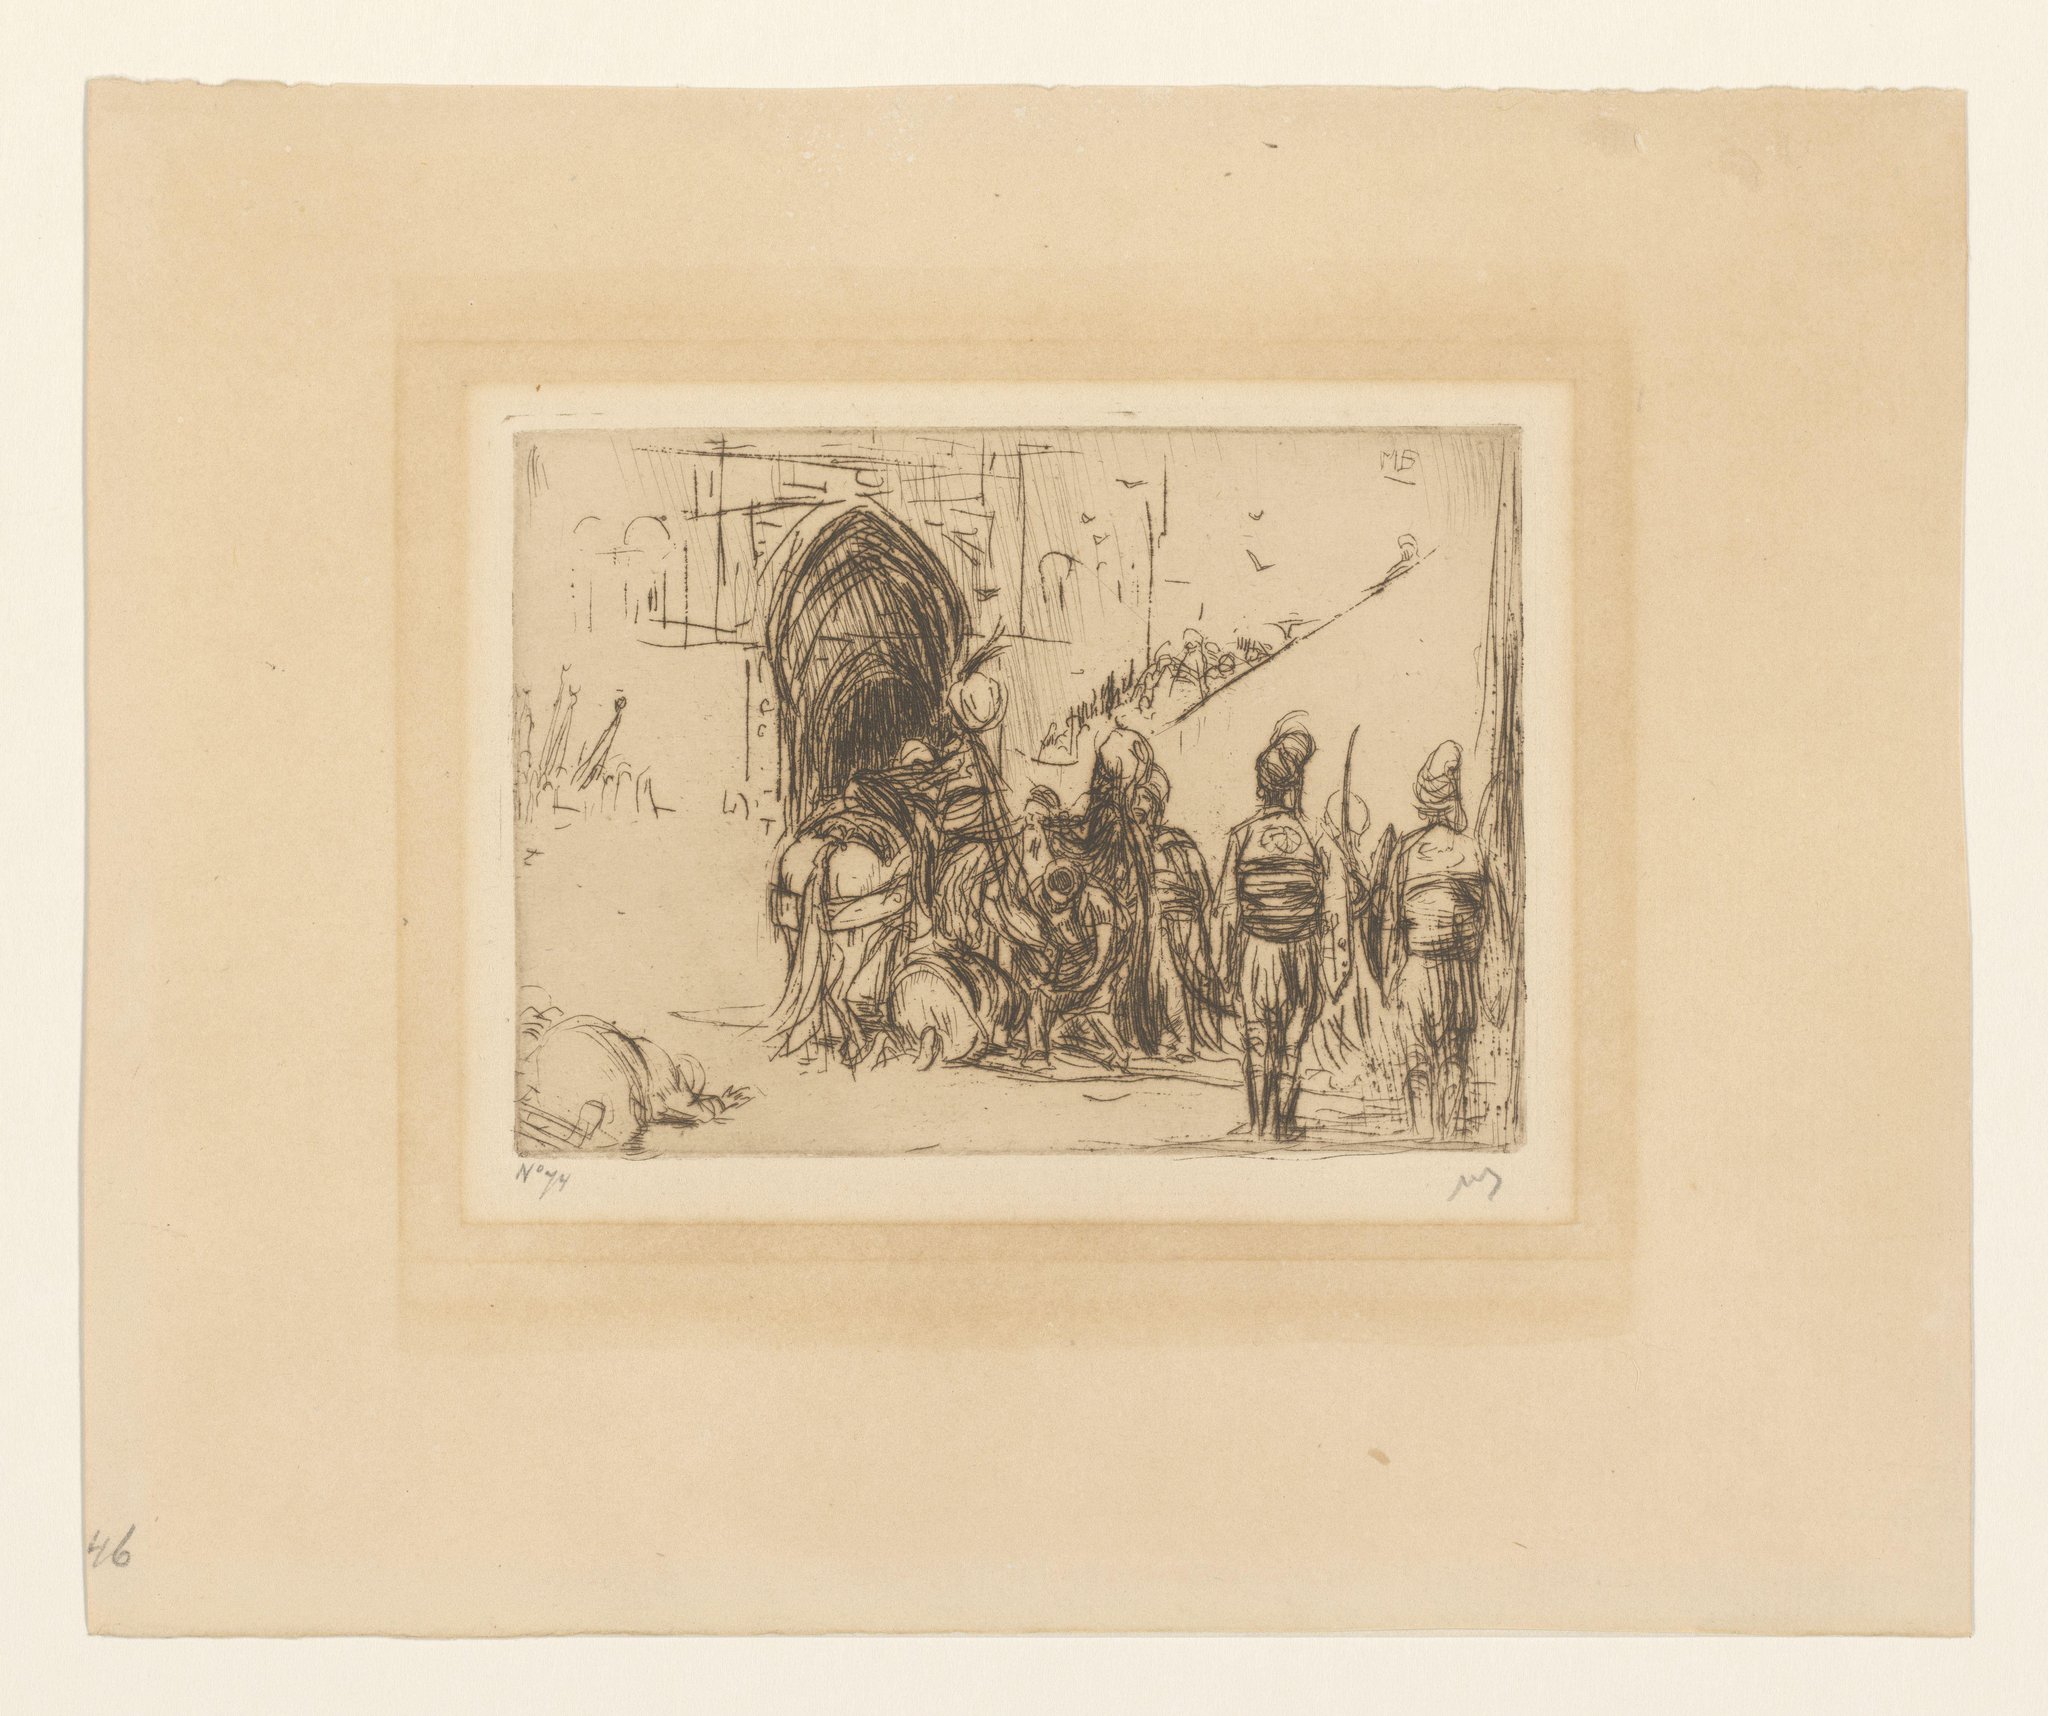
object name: print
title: Hoog bezoek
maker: marius bauer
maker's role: draughtsman, print maker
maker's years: 1867-1932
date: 1889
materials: paper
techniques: etching, intaglio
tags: contrast between important and unimportant people; the inferior before the superior, the weak before the mighty, kneeling figure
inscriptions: collector's mark: Lugt 2760, collector's mark: Lugt 2228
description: Een man stapt op de rug van een knielende man om zijn paard te bestijgen of er juist af te stappen. Links op de voorgrond knielende figuren die hun armen op de grond uitstrekken, rechts op de voorgrond enkele schildwachten.